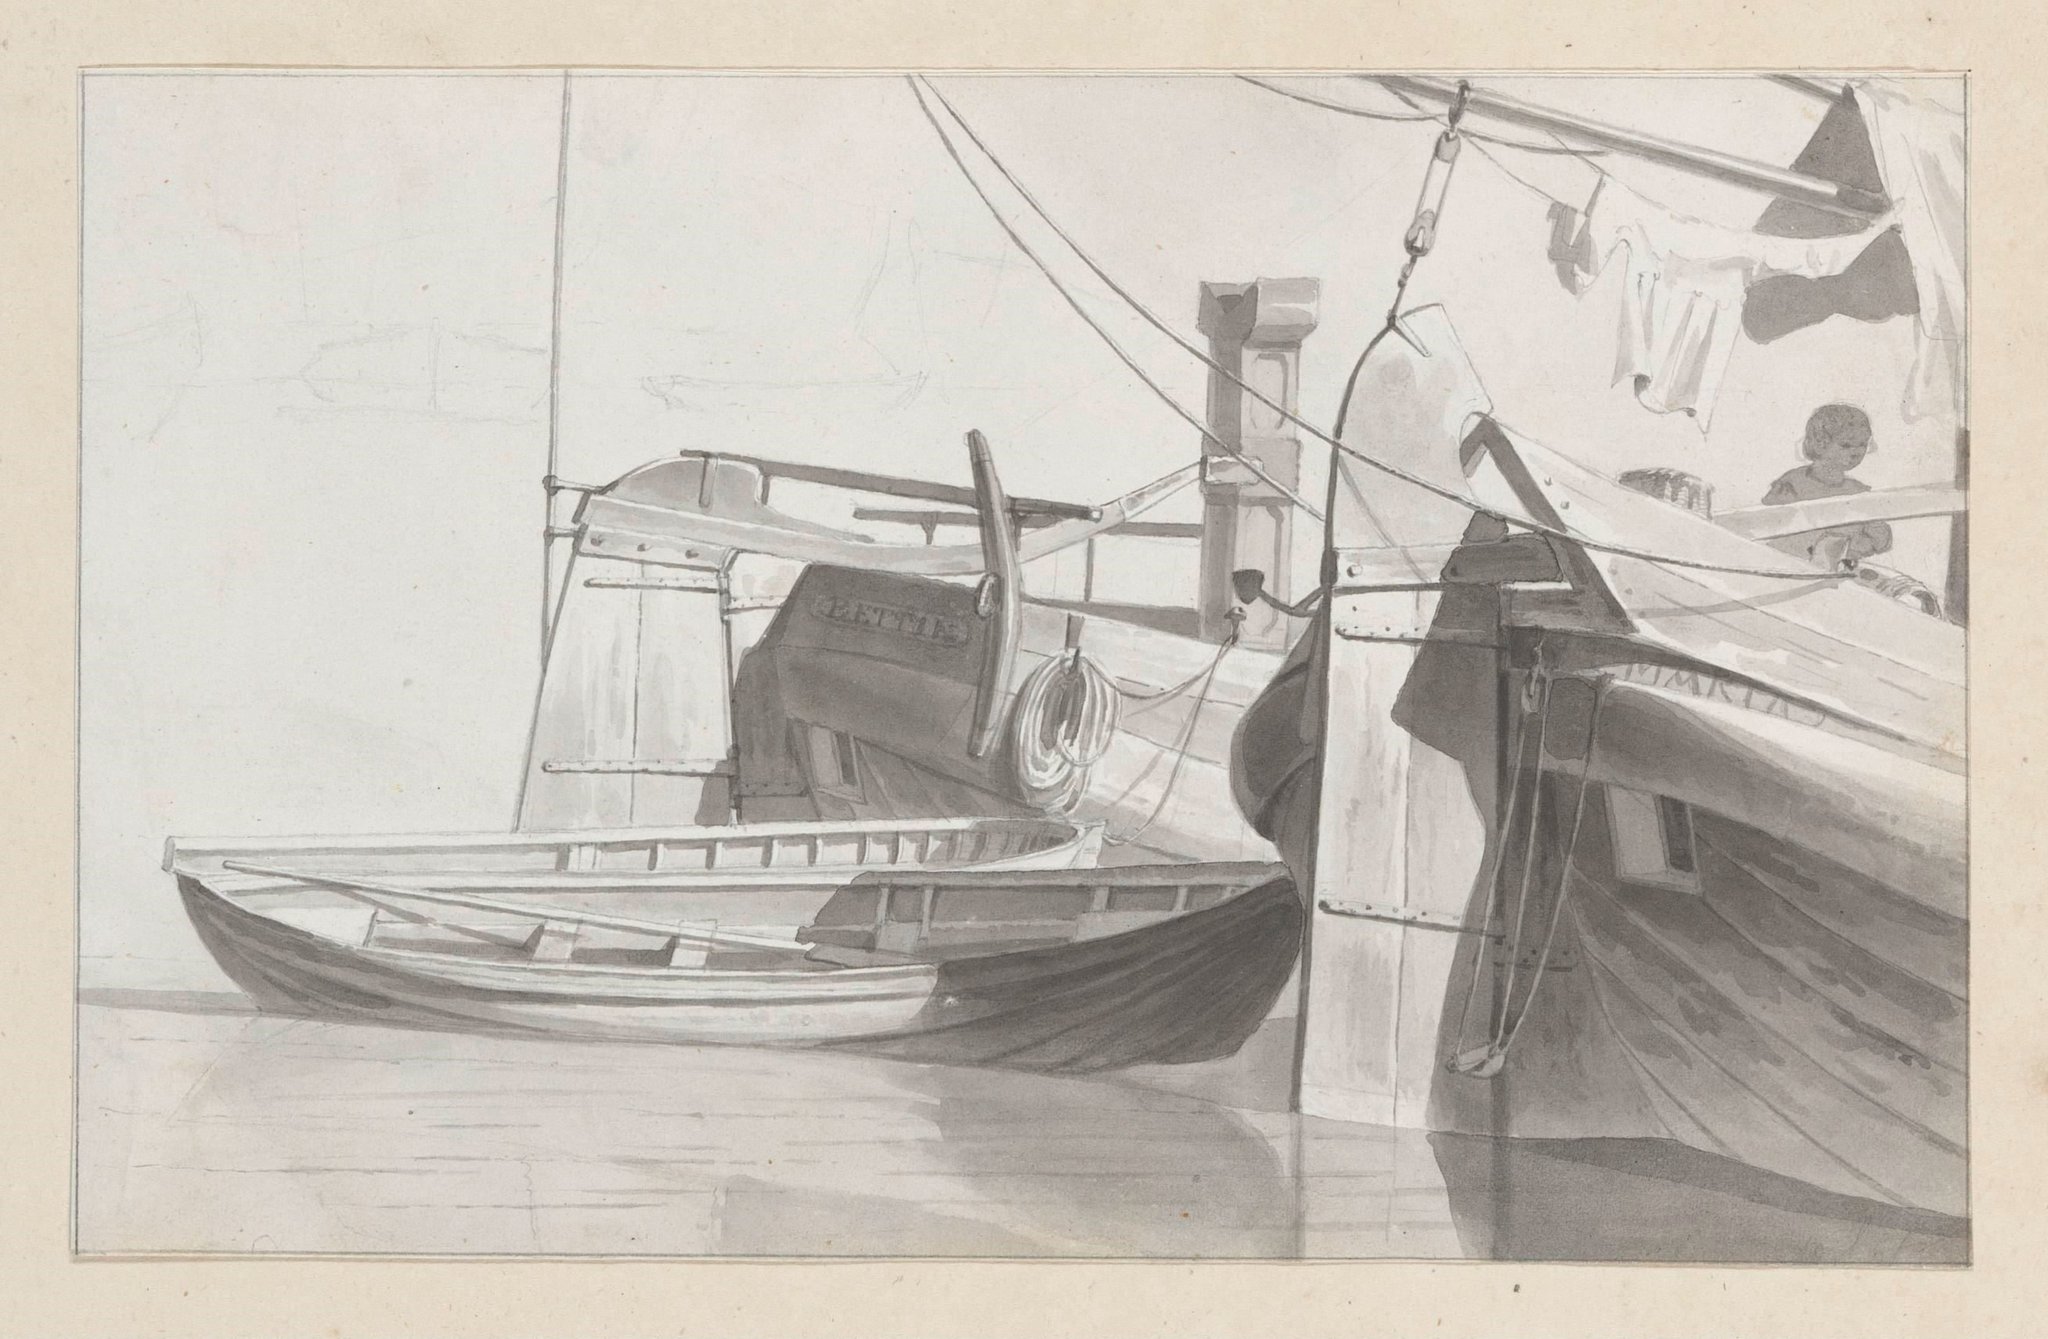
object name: drawing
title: Afgemeerde schepen met sloepen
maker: hendrik abraham klinkhamer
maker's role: draughtsman, painter, print maker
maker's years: 1810-1872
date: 1820-1872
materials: paper, pencil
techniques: brush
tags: sailing-ship, sailing-boat